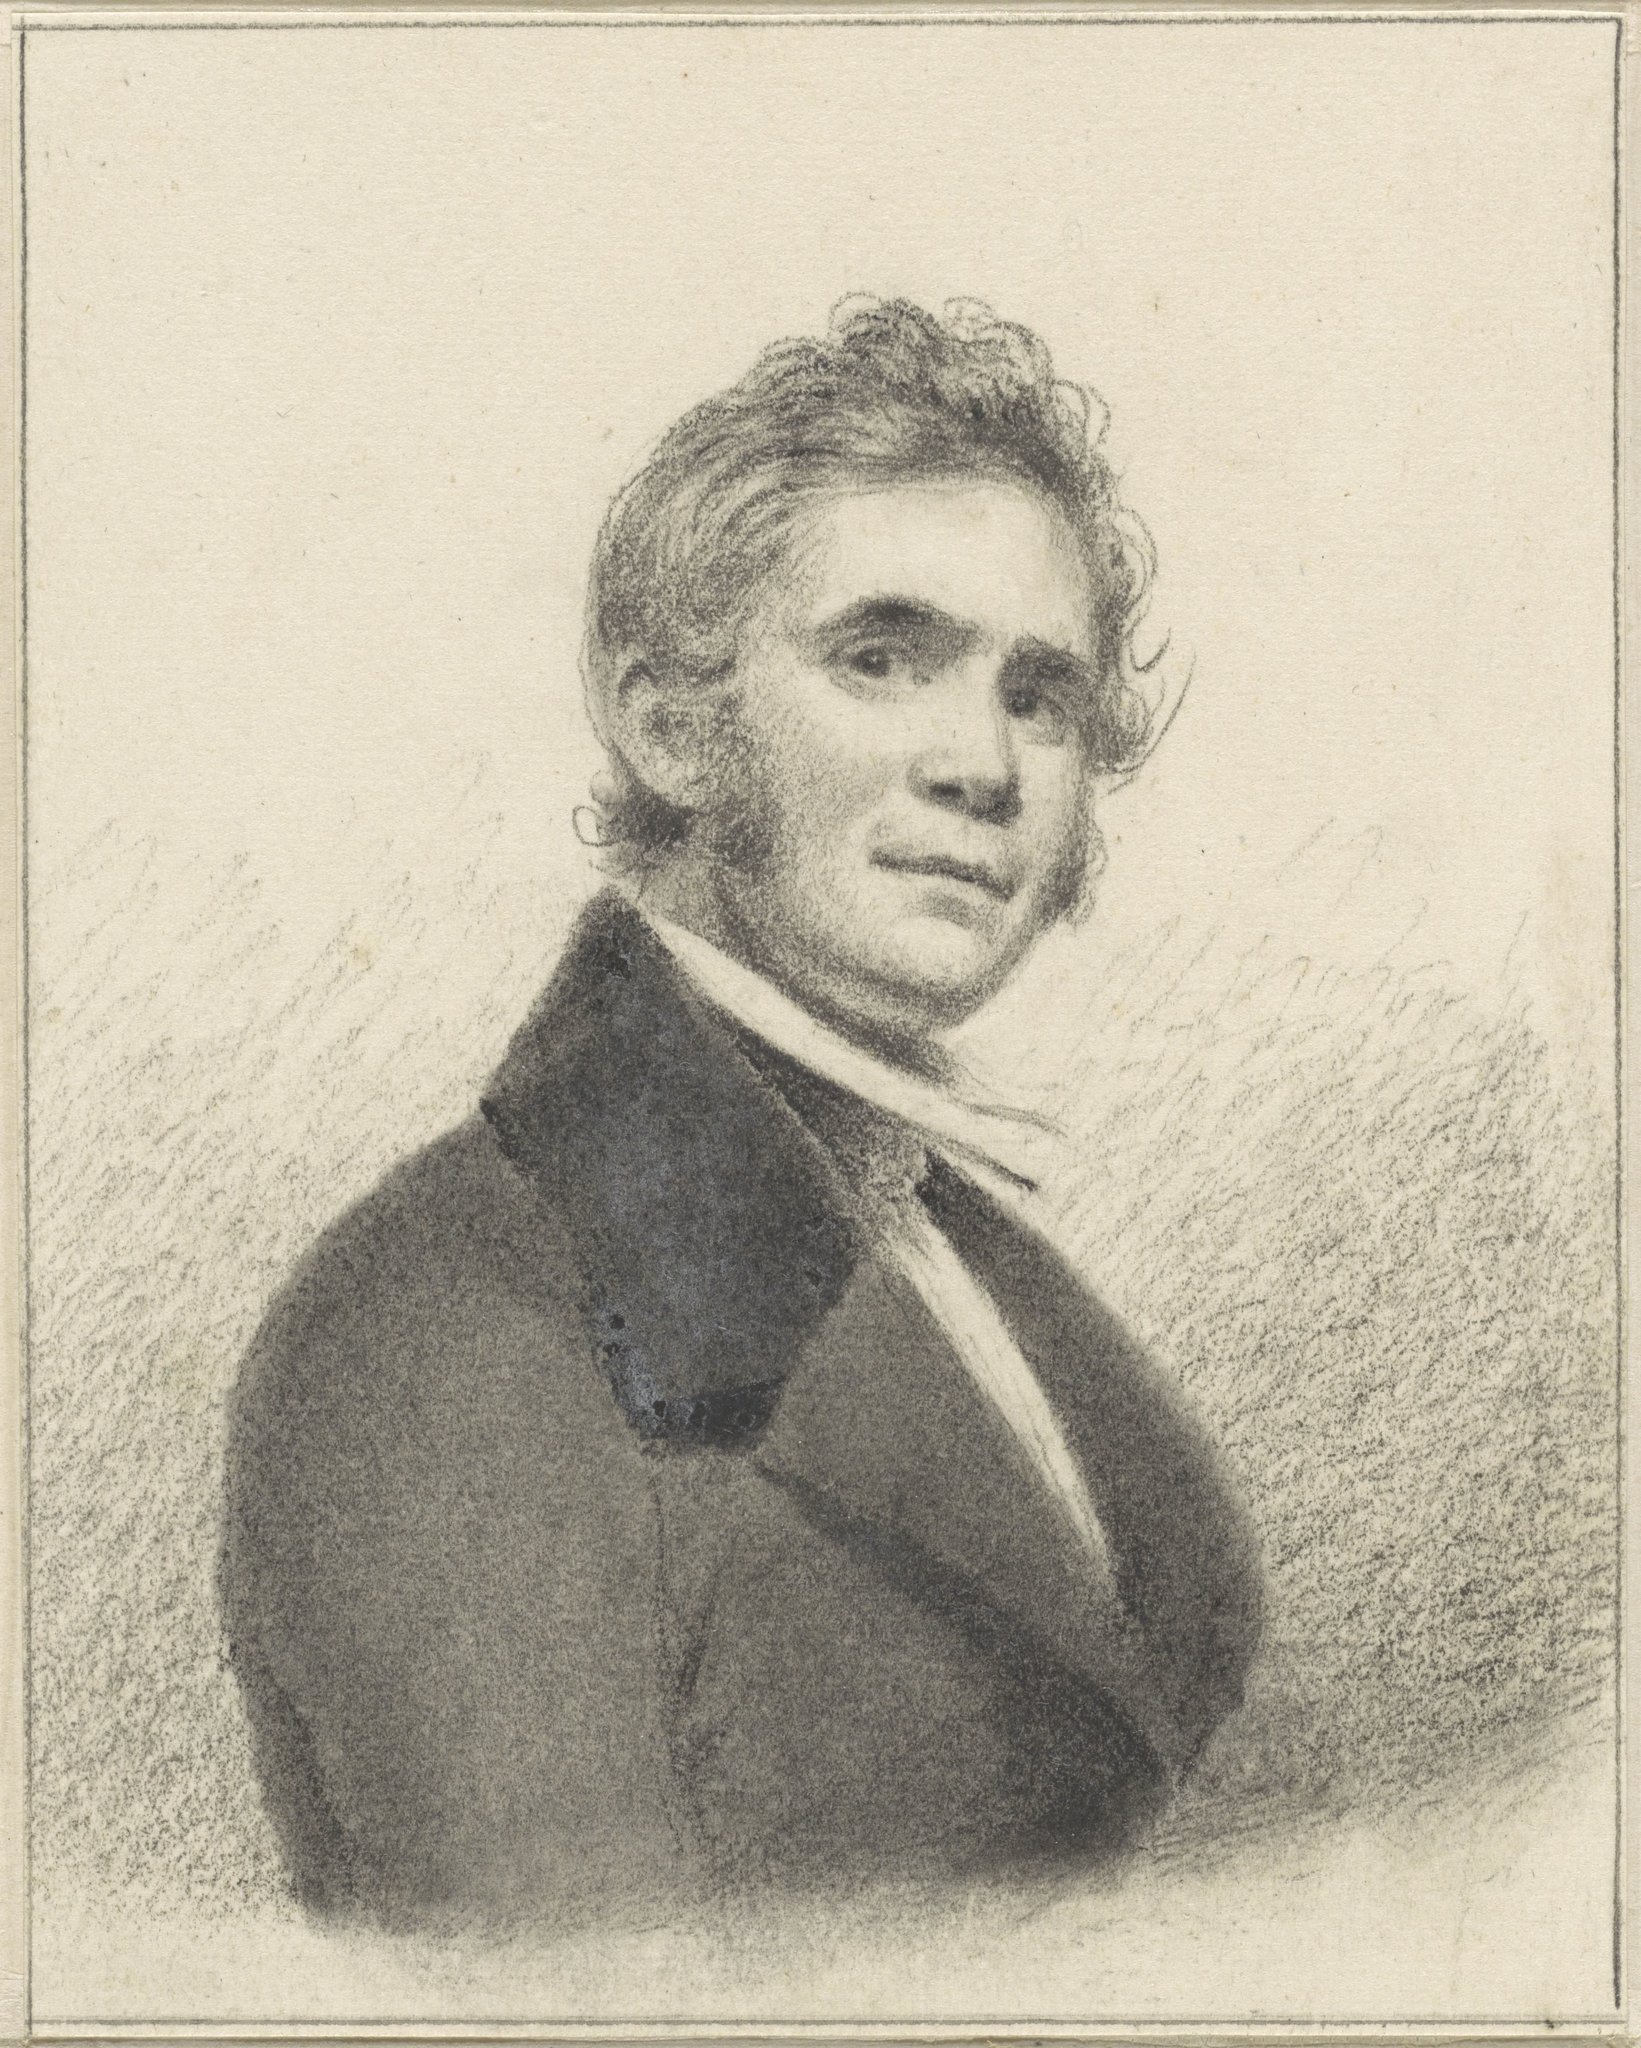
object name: drawing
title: Zelfportret van Jacobus Schoemaker Doyer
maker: jacobus schoemaker doyer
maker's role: draughtsman, painter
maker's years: 1792-1867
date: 1802-1867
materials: chalk, paper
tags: painter, draughtsman, jacobus schoemaker doyer, historical persons, portrait, self-portrait of artist